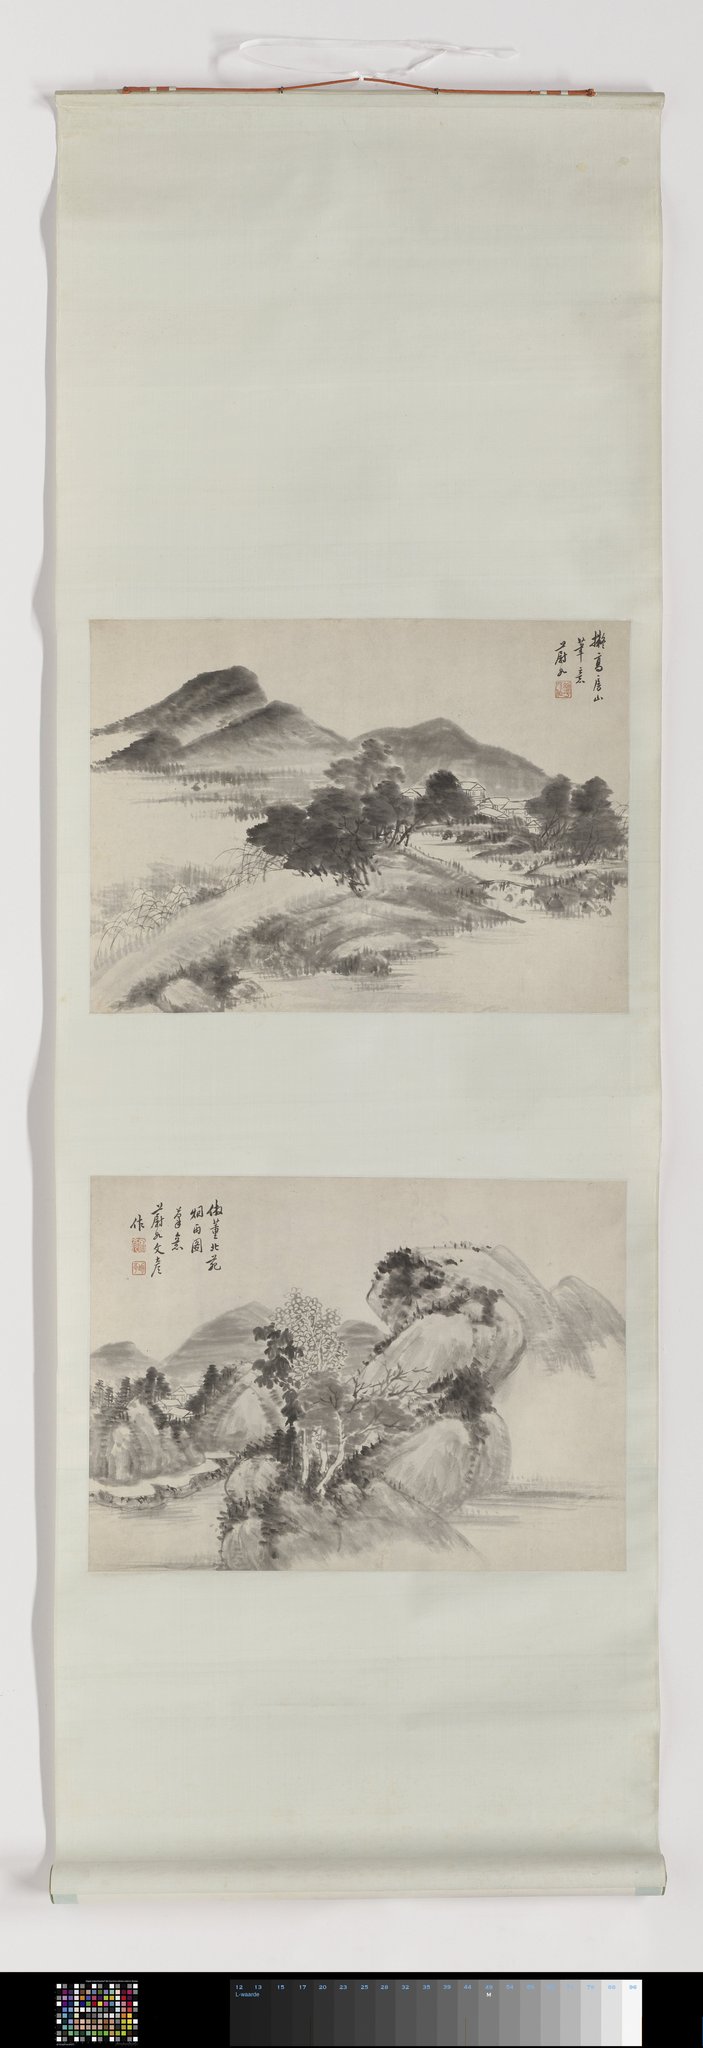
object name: hanging scroll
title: Rolschilderingen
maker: xiang wenyan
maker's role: painter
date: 1850-1900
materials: ink, paper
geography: huai'an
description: Landscapes. Xiang Wenyan. China. Second half of 19th century. Ink on paper. Two album pages have been joined to form a vertical scroll. Although using only one colour, the artist manages to give the painting tremendous variety. According to the inscriptions the paintings are in the styles of famous artists of the 10th and 13th centuries. Imitating the style of another artist was a painter's way of paying tribute to a famous master.